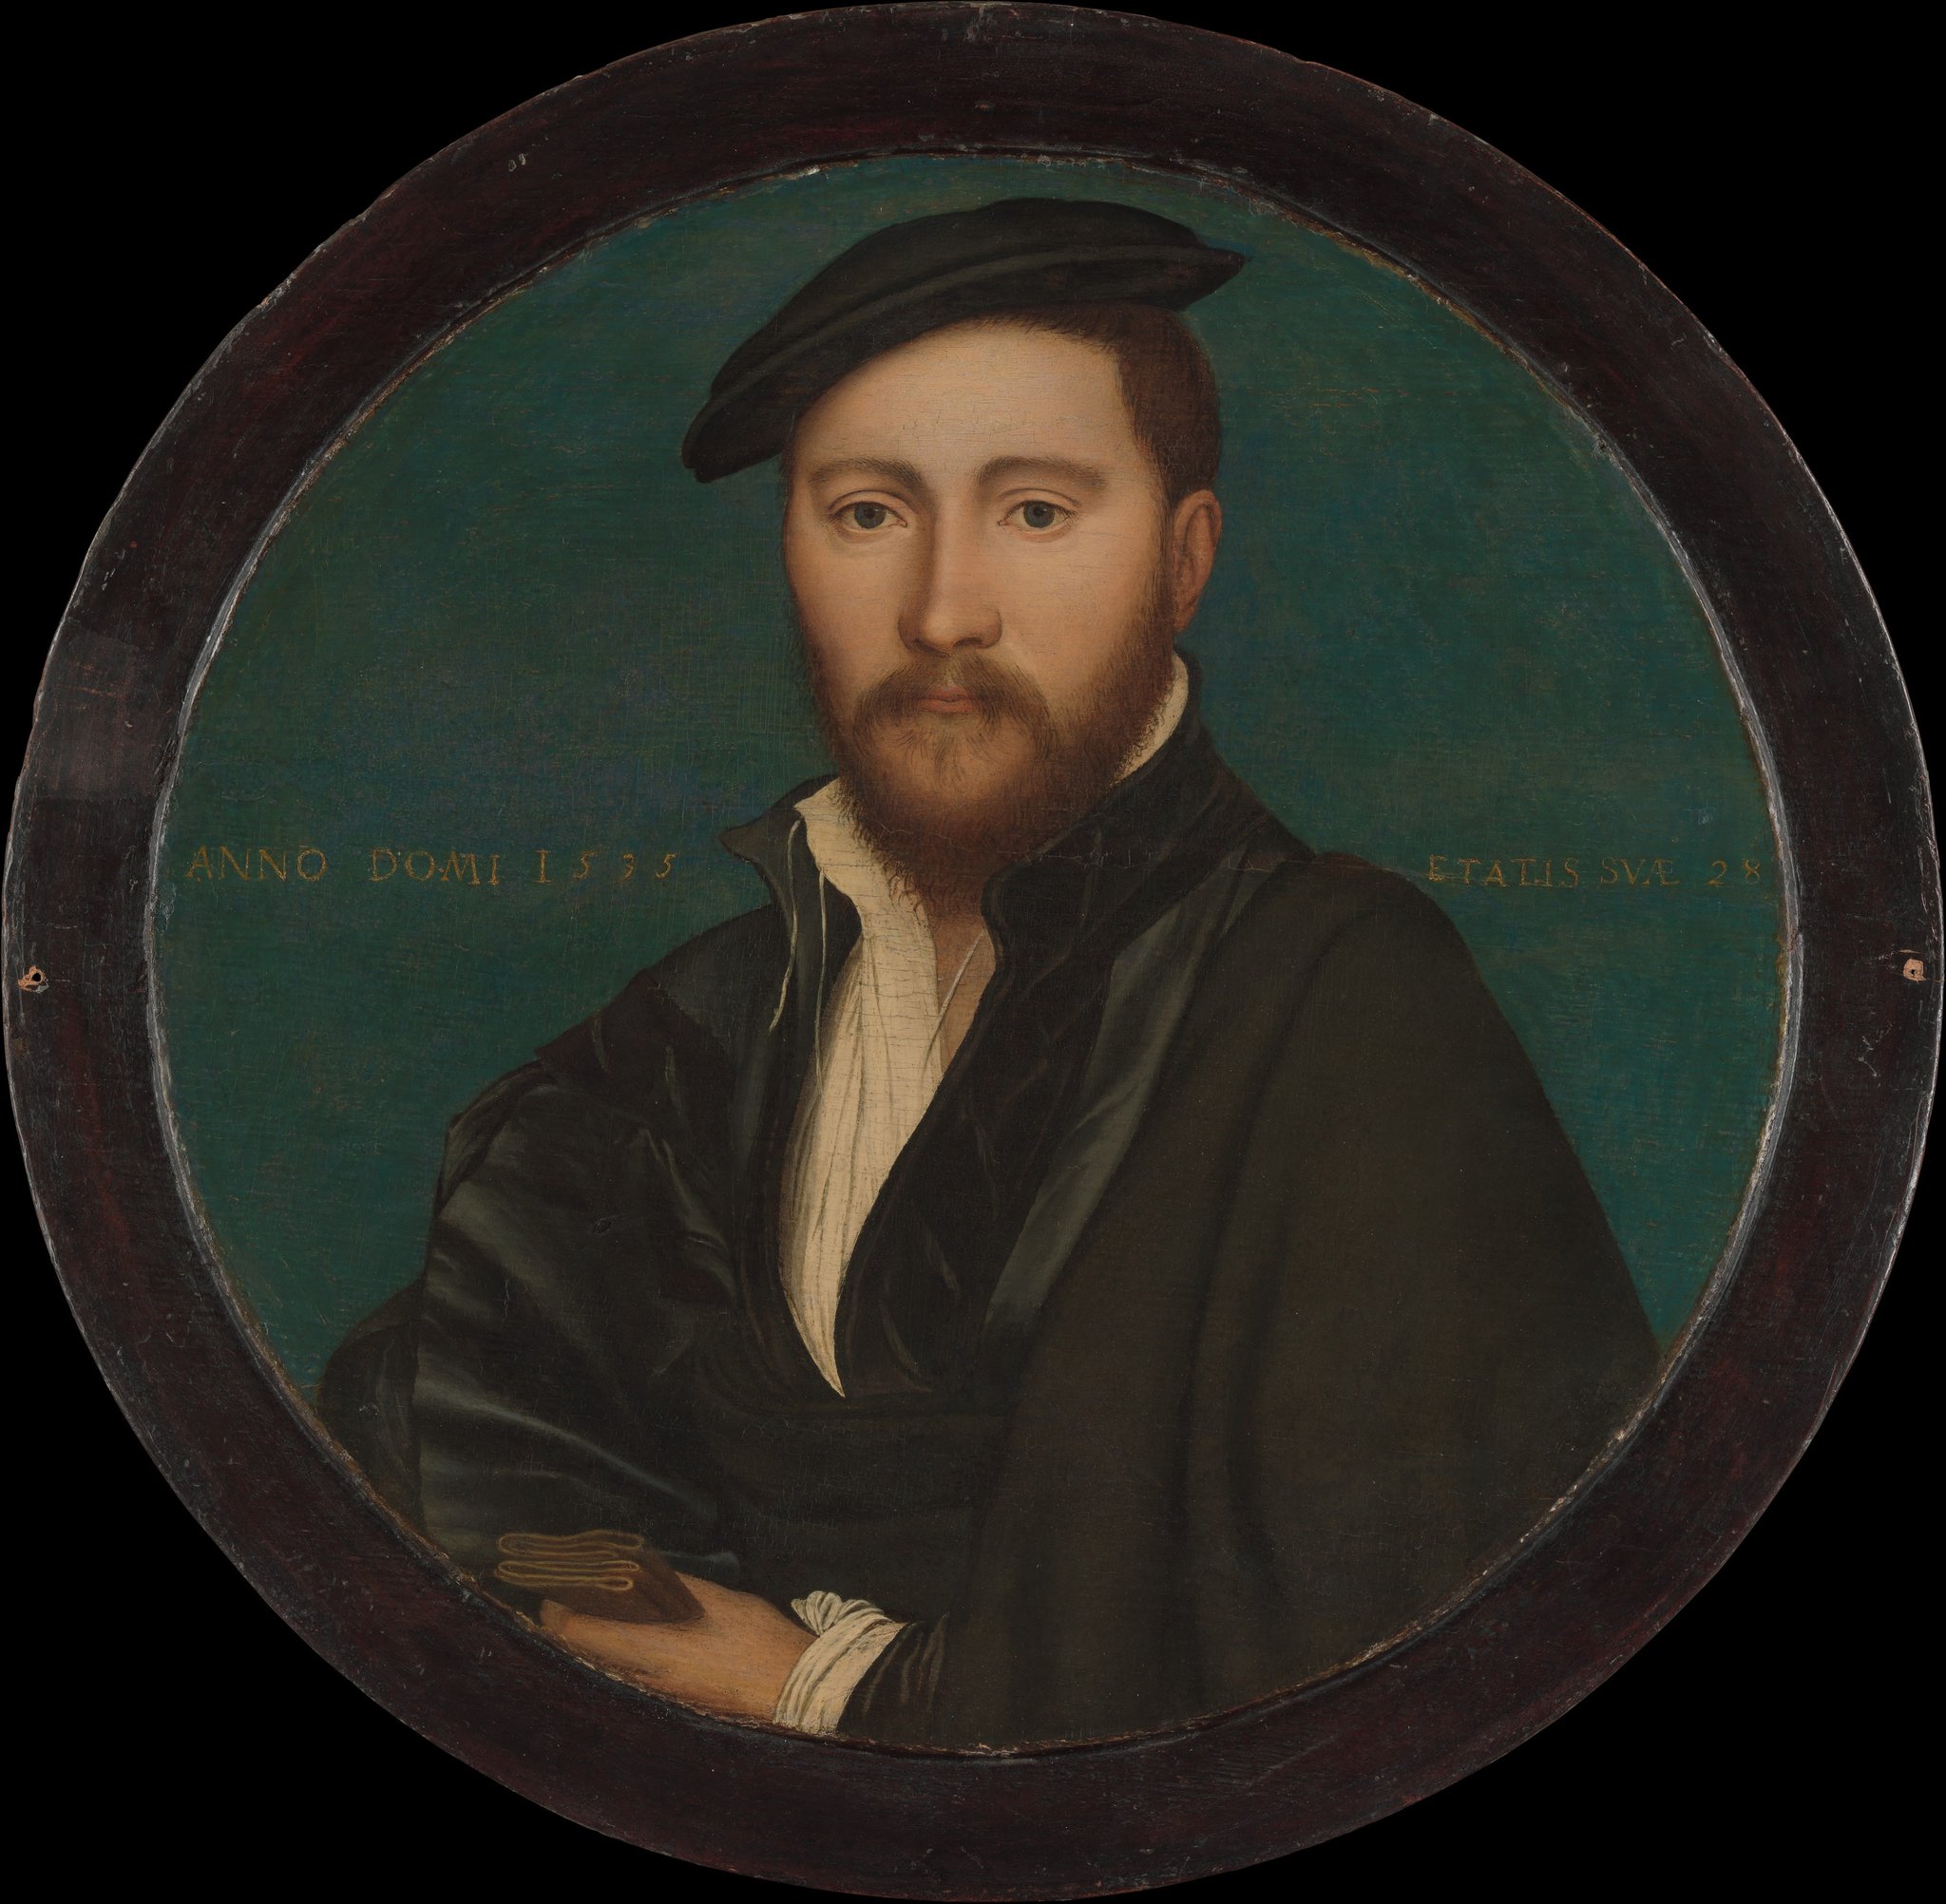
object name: painting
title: Portrait of a Man (Sir Ralph Sadler?)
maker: hans holbein the younger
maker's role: artist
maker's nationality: german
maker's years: 1497-1543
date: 1535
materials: gold, wood, oil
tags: men,portraits